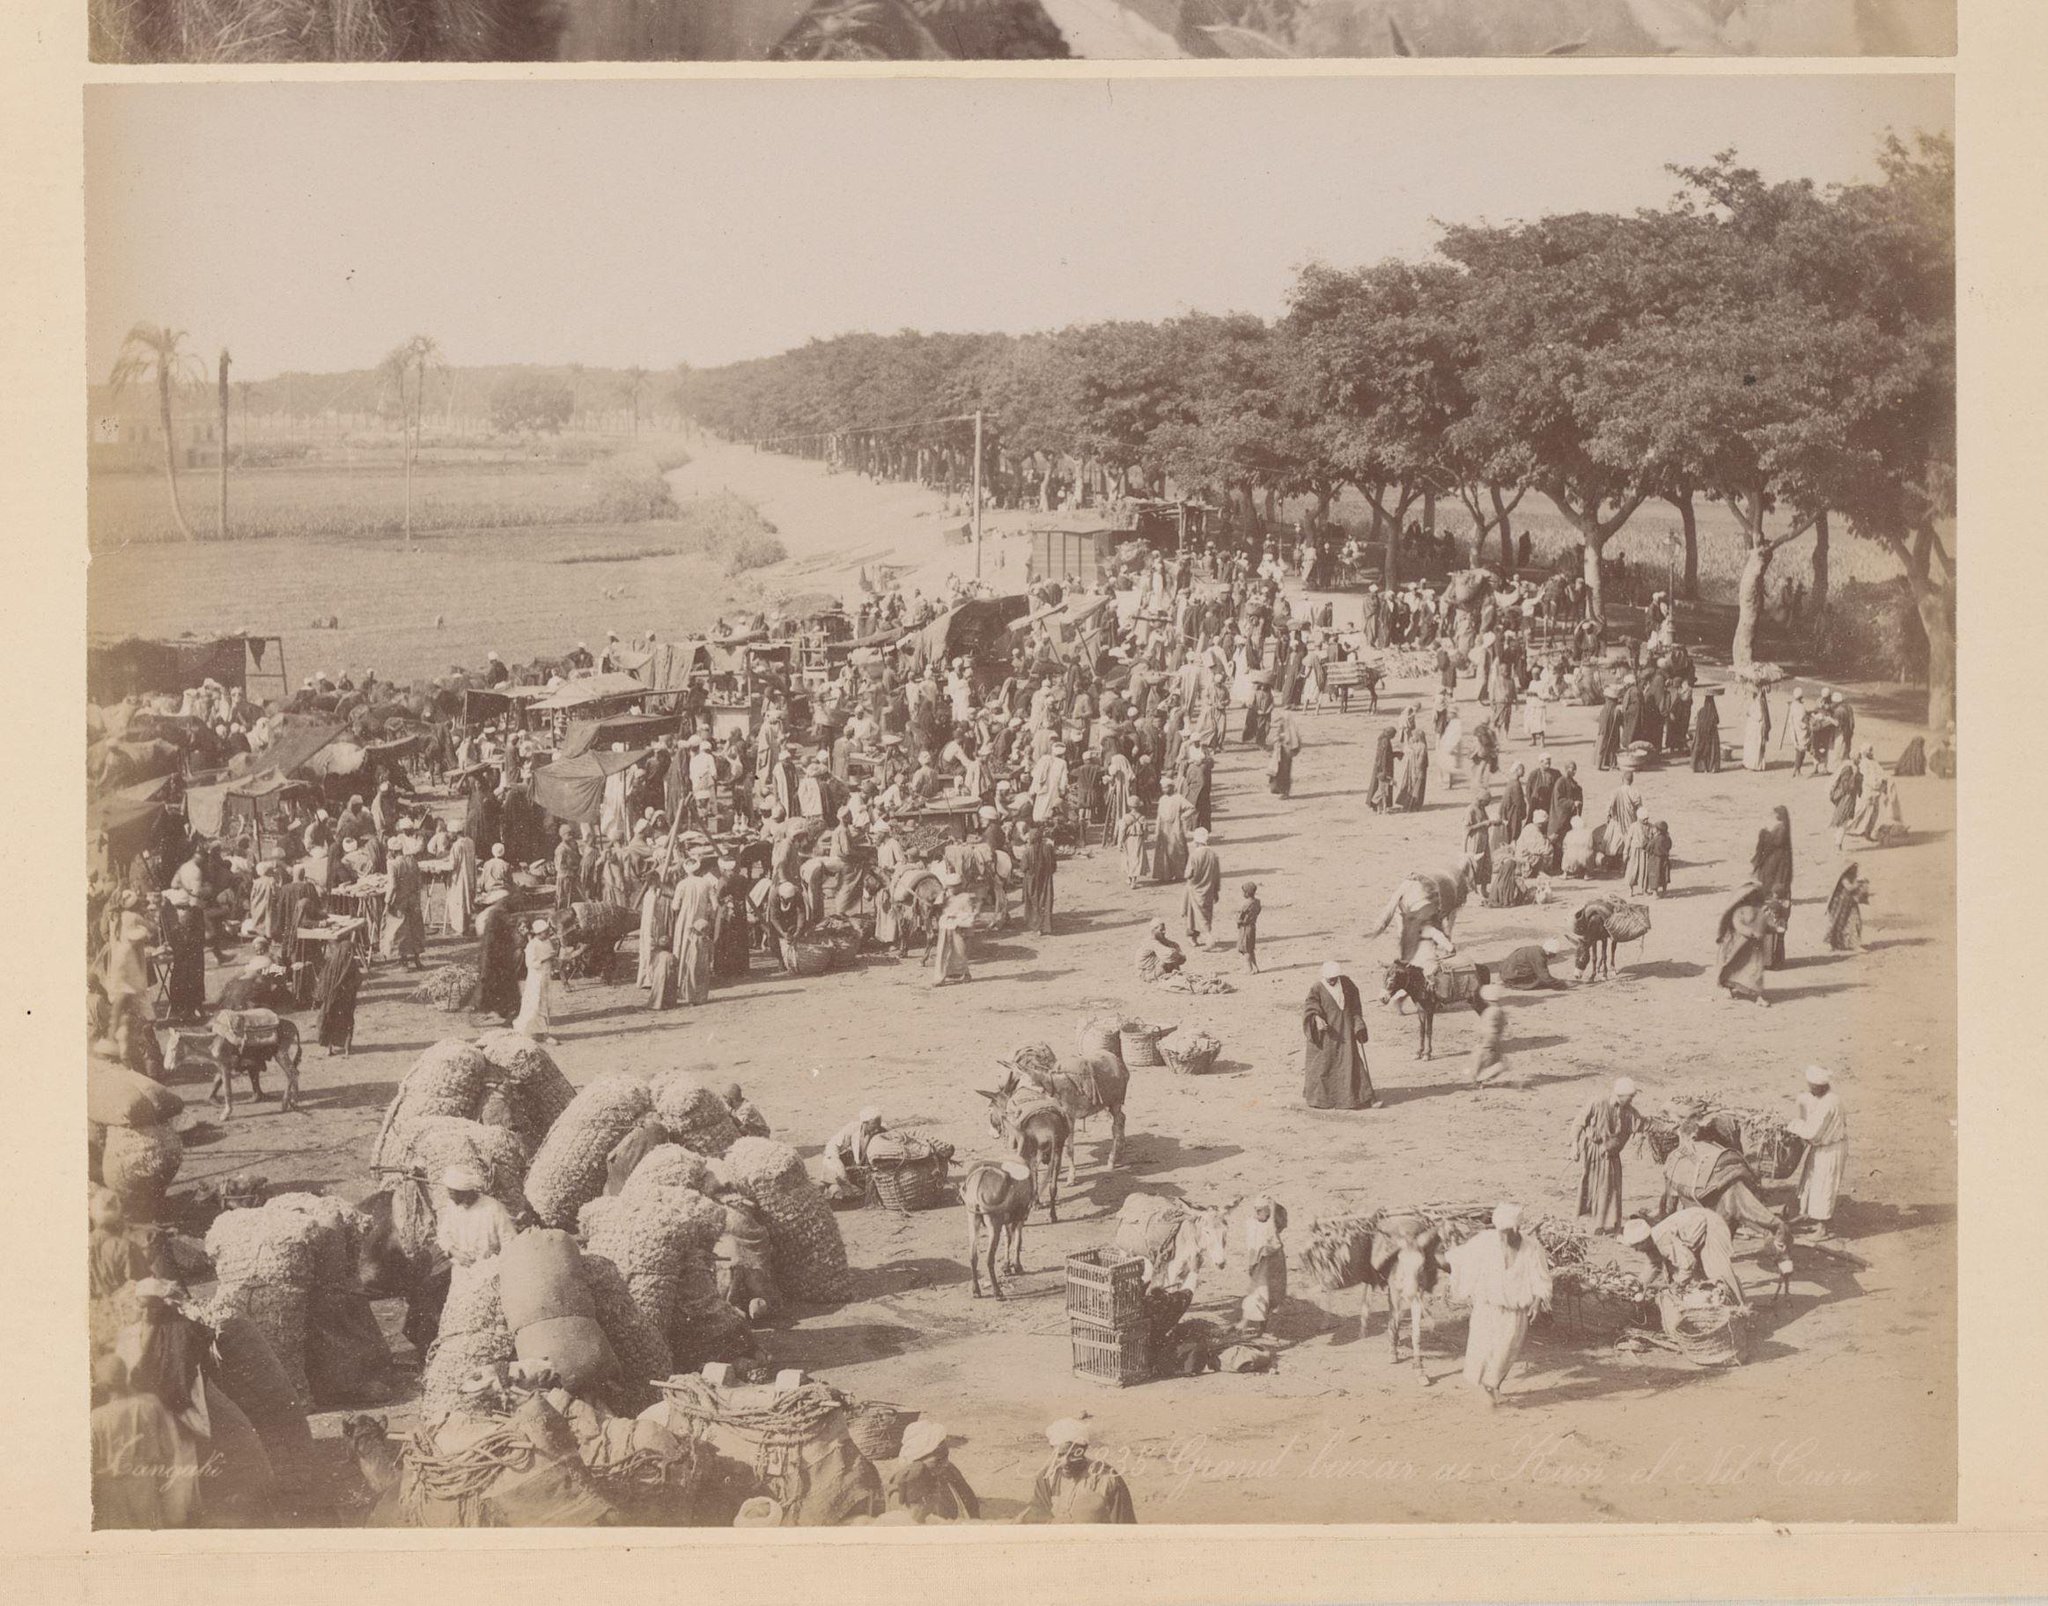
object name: photograph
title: Gezicht op een straatmarkt in Caïro, Egypte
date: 1890-1900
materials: cardboard, photographic support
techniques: albumen print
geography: cairo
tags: market, street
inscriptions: inscription: ‘No. 835, Grand Bazar au Kasr-el-Nil, Caire’, name: ‘Zangaki’